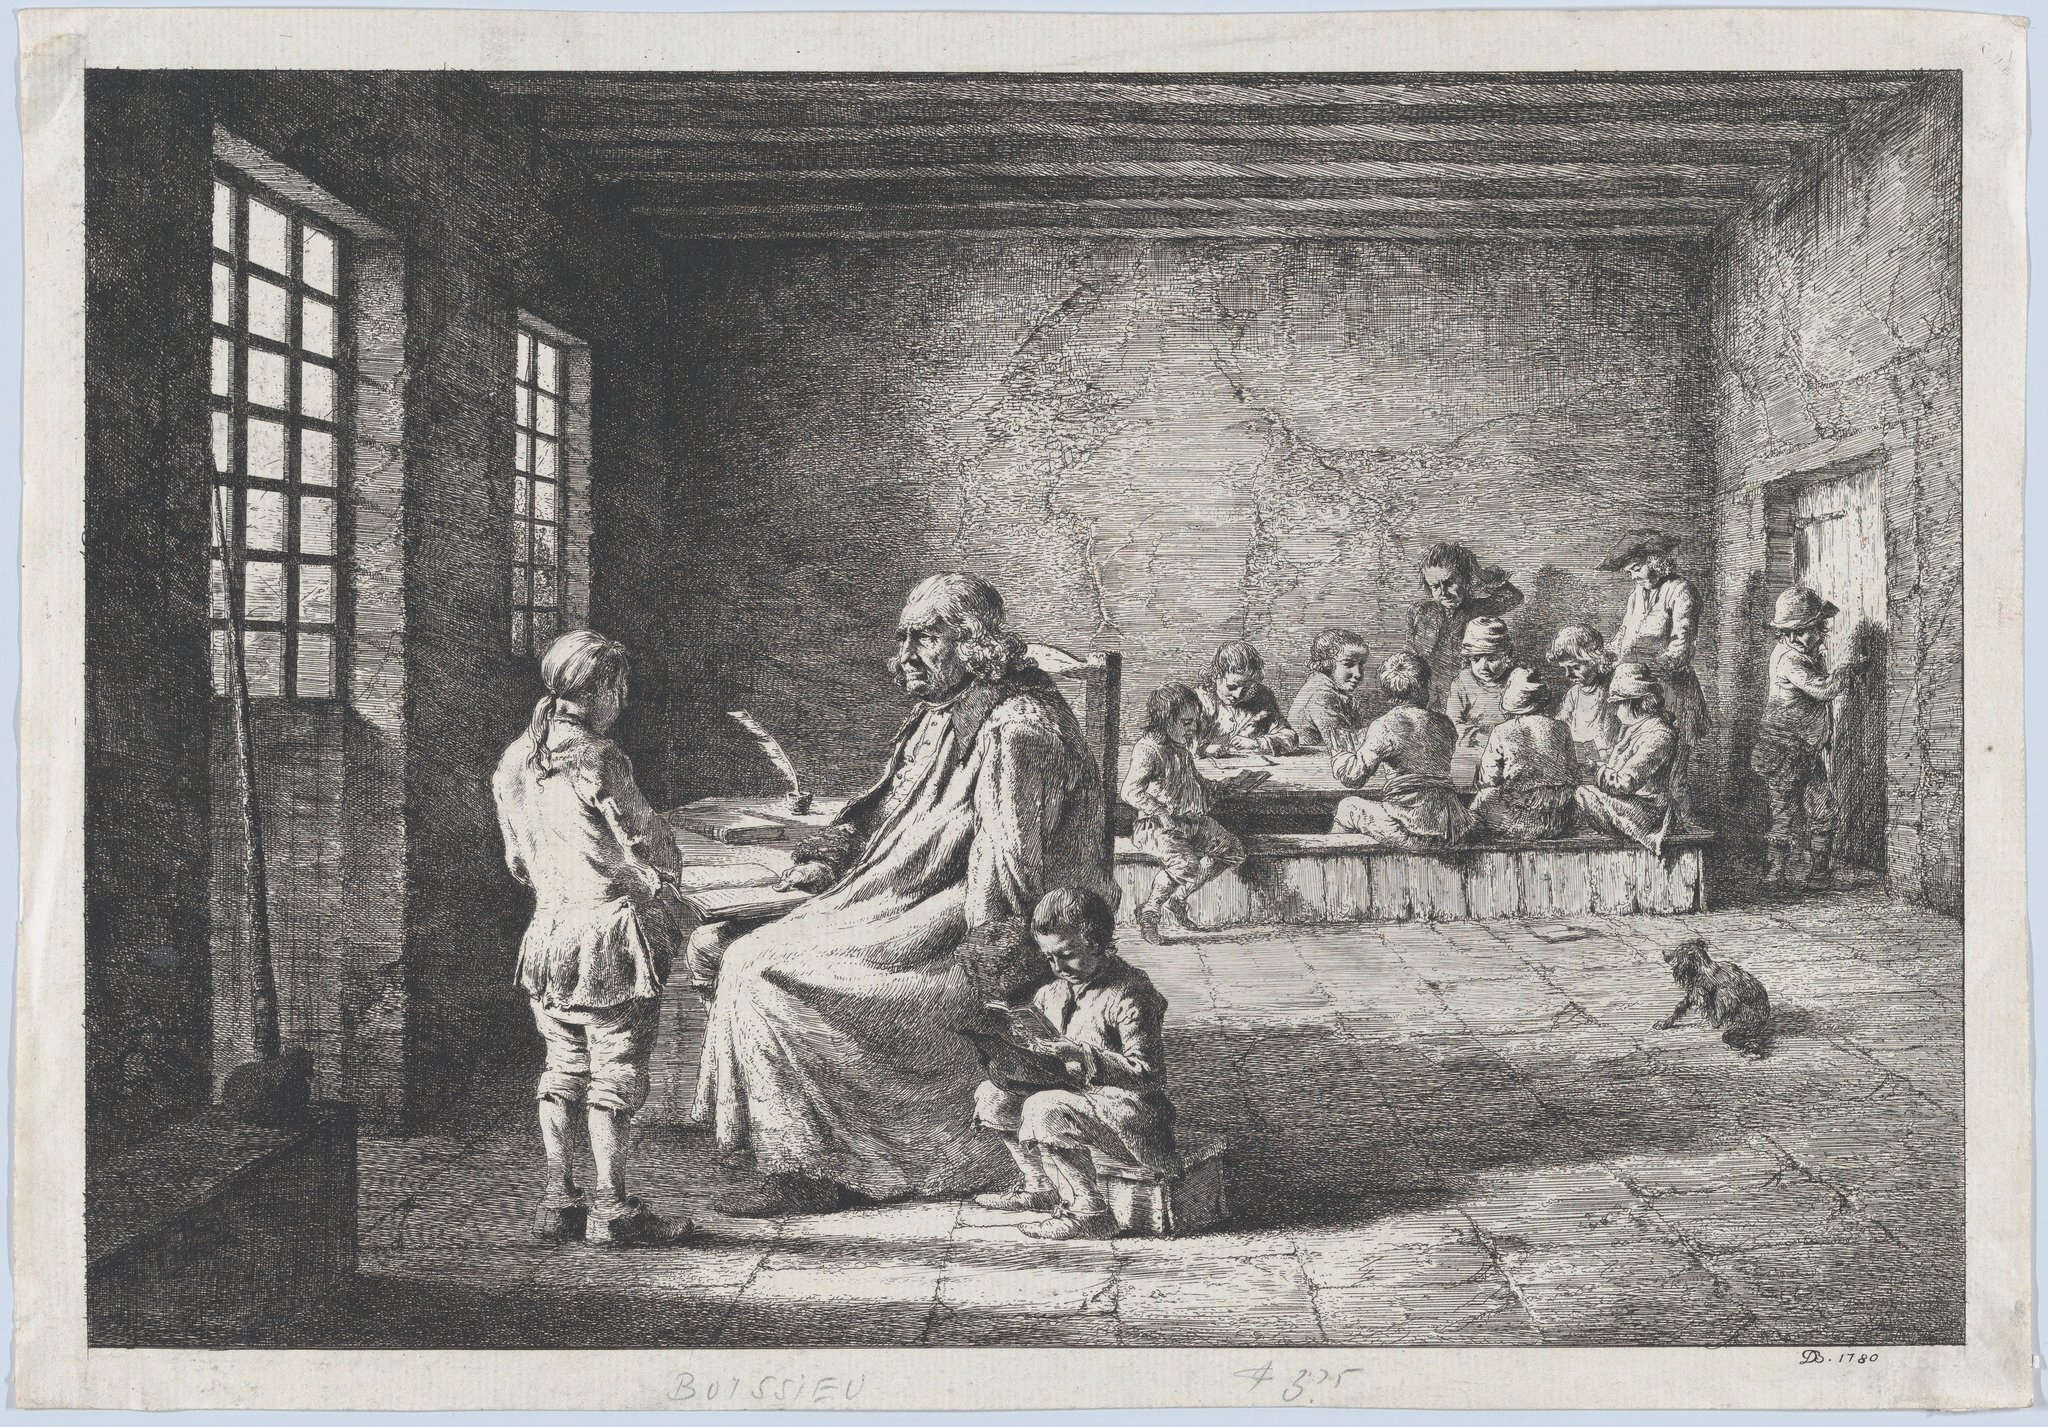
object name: print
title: The School Master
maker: jean jacques de boissieu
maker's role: artist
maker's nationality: french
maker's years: 1736-1810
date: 1780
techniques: drypoint, etching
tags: boys,men,teachers